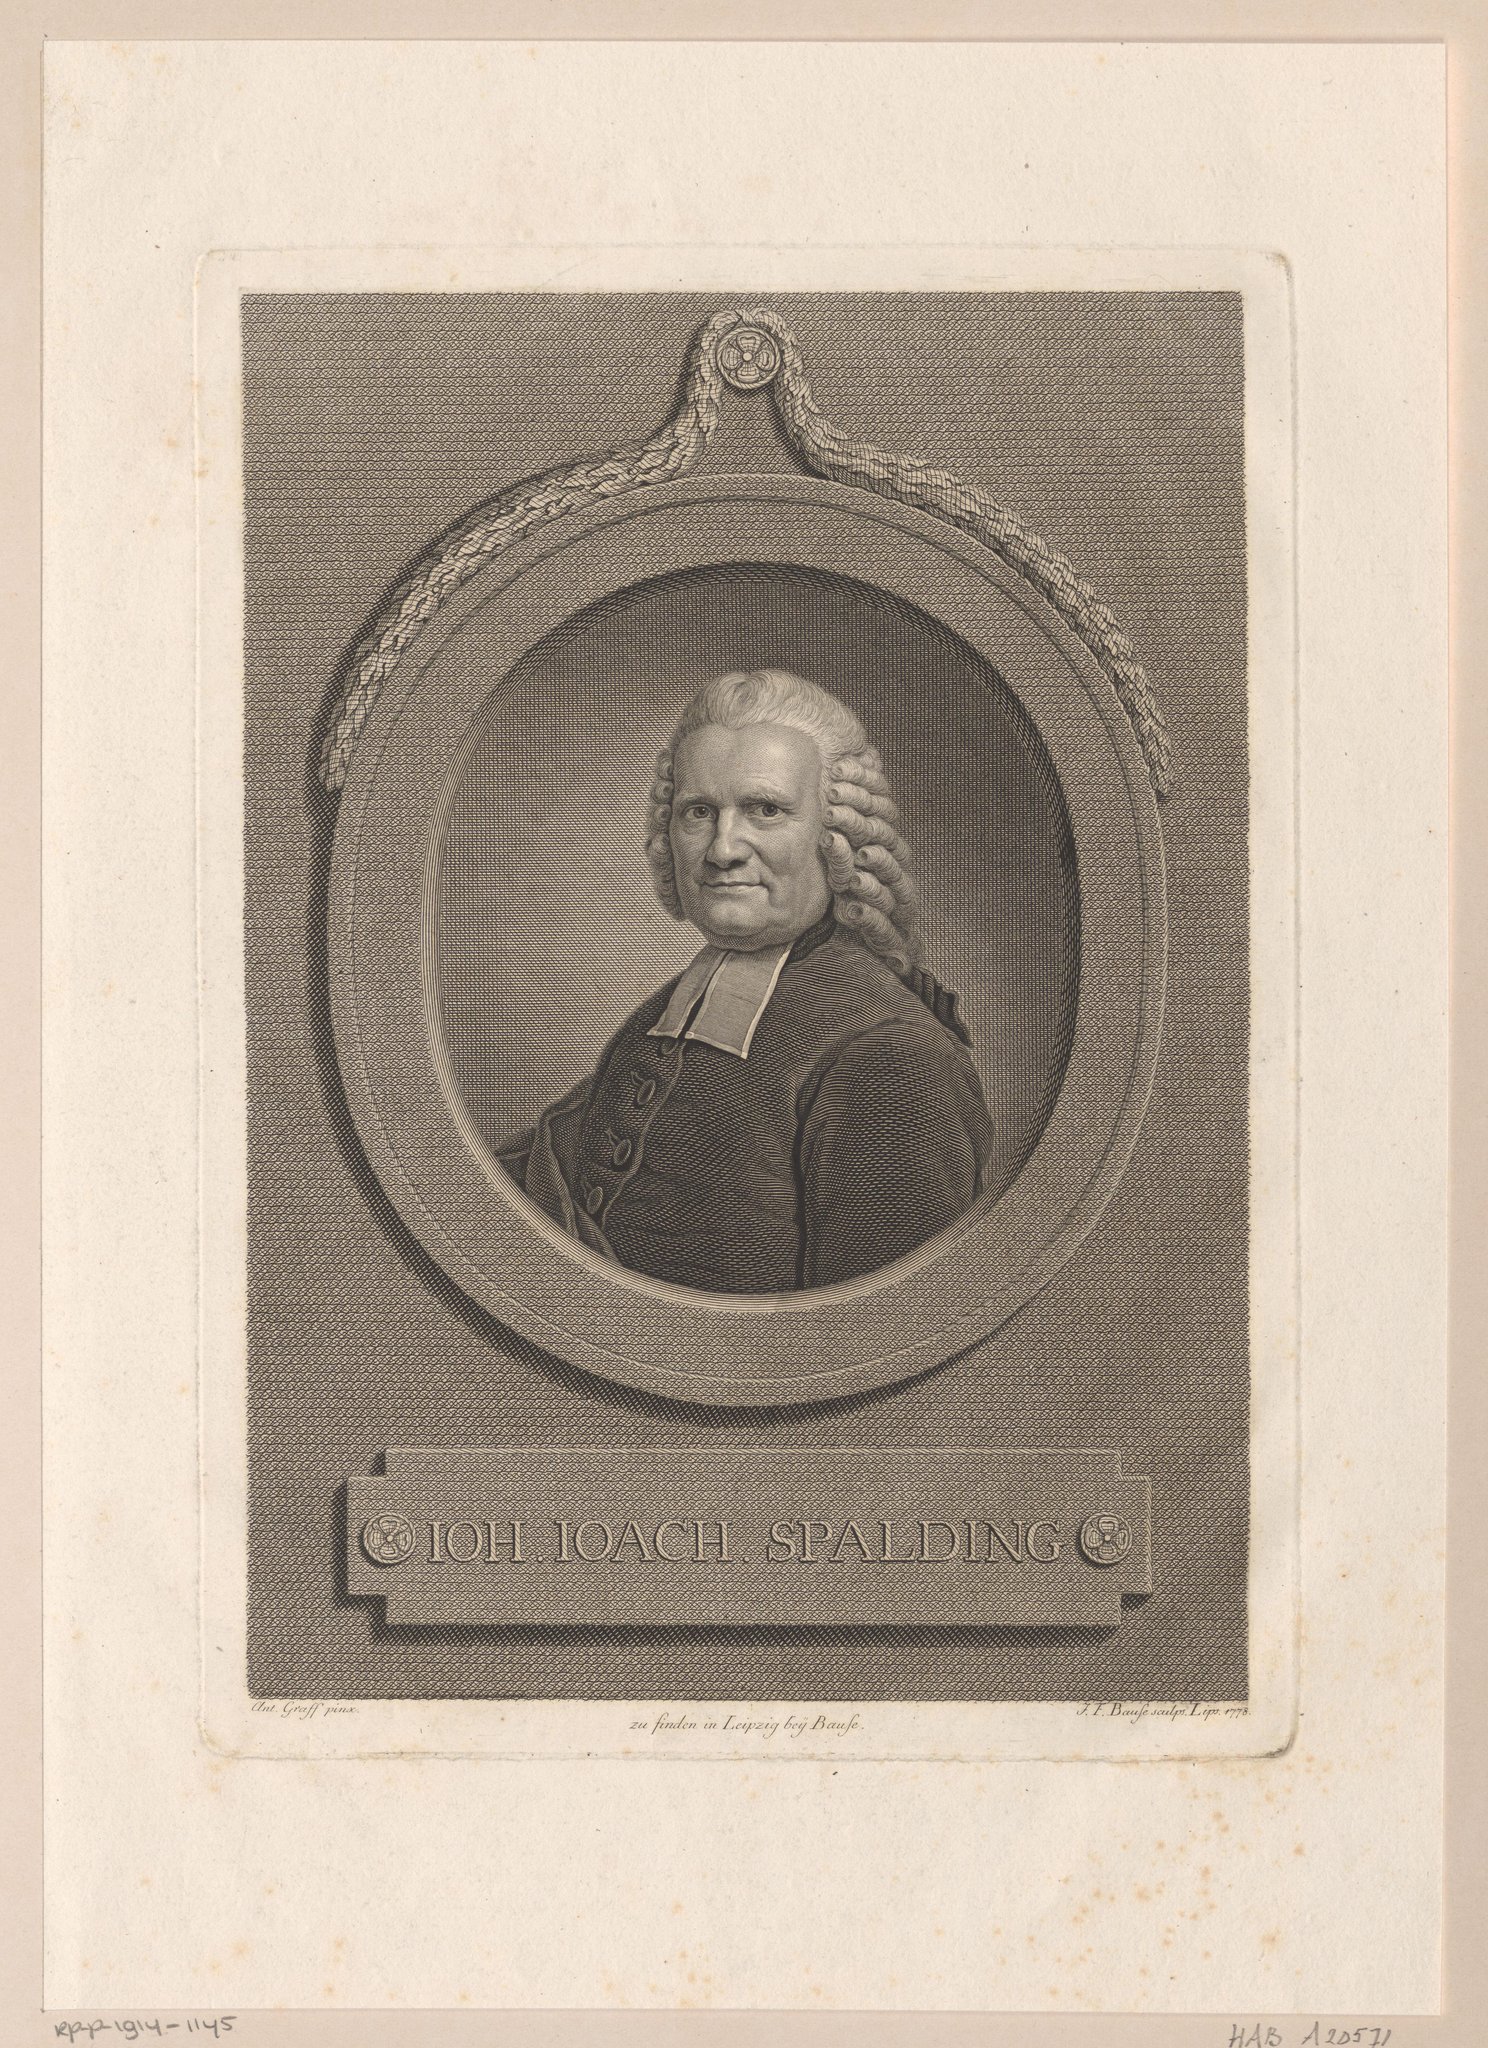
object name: print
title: Portret van Johann Joachim Spalding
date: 1778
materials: paper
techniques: engraving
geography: leipzig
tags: berlin, johann joachim spalding, theologian, historical persons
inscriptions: collector's mark: Lugt 2228